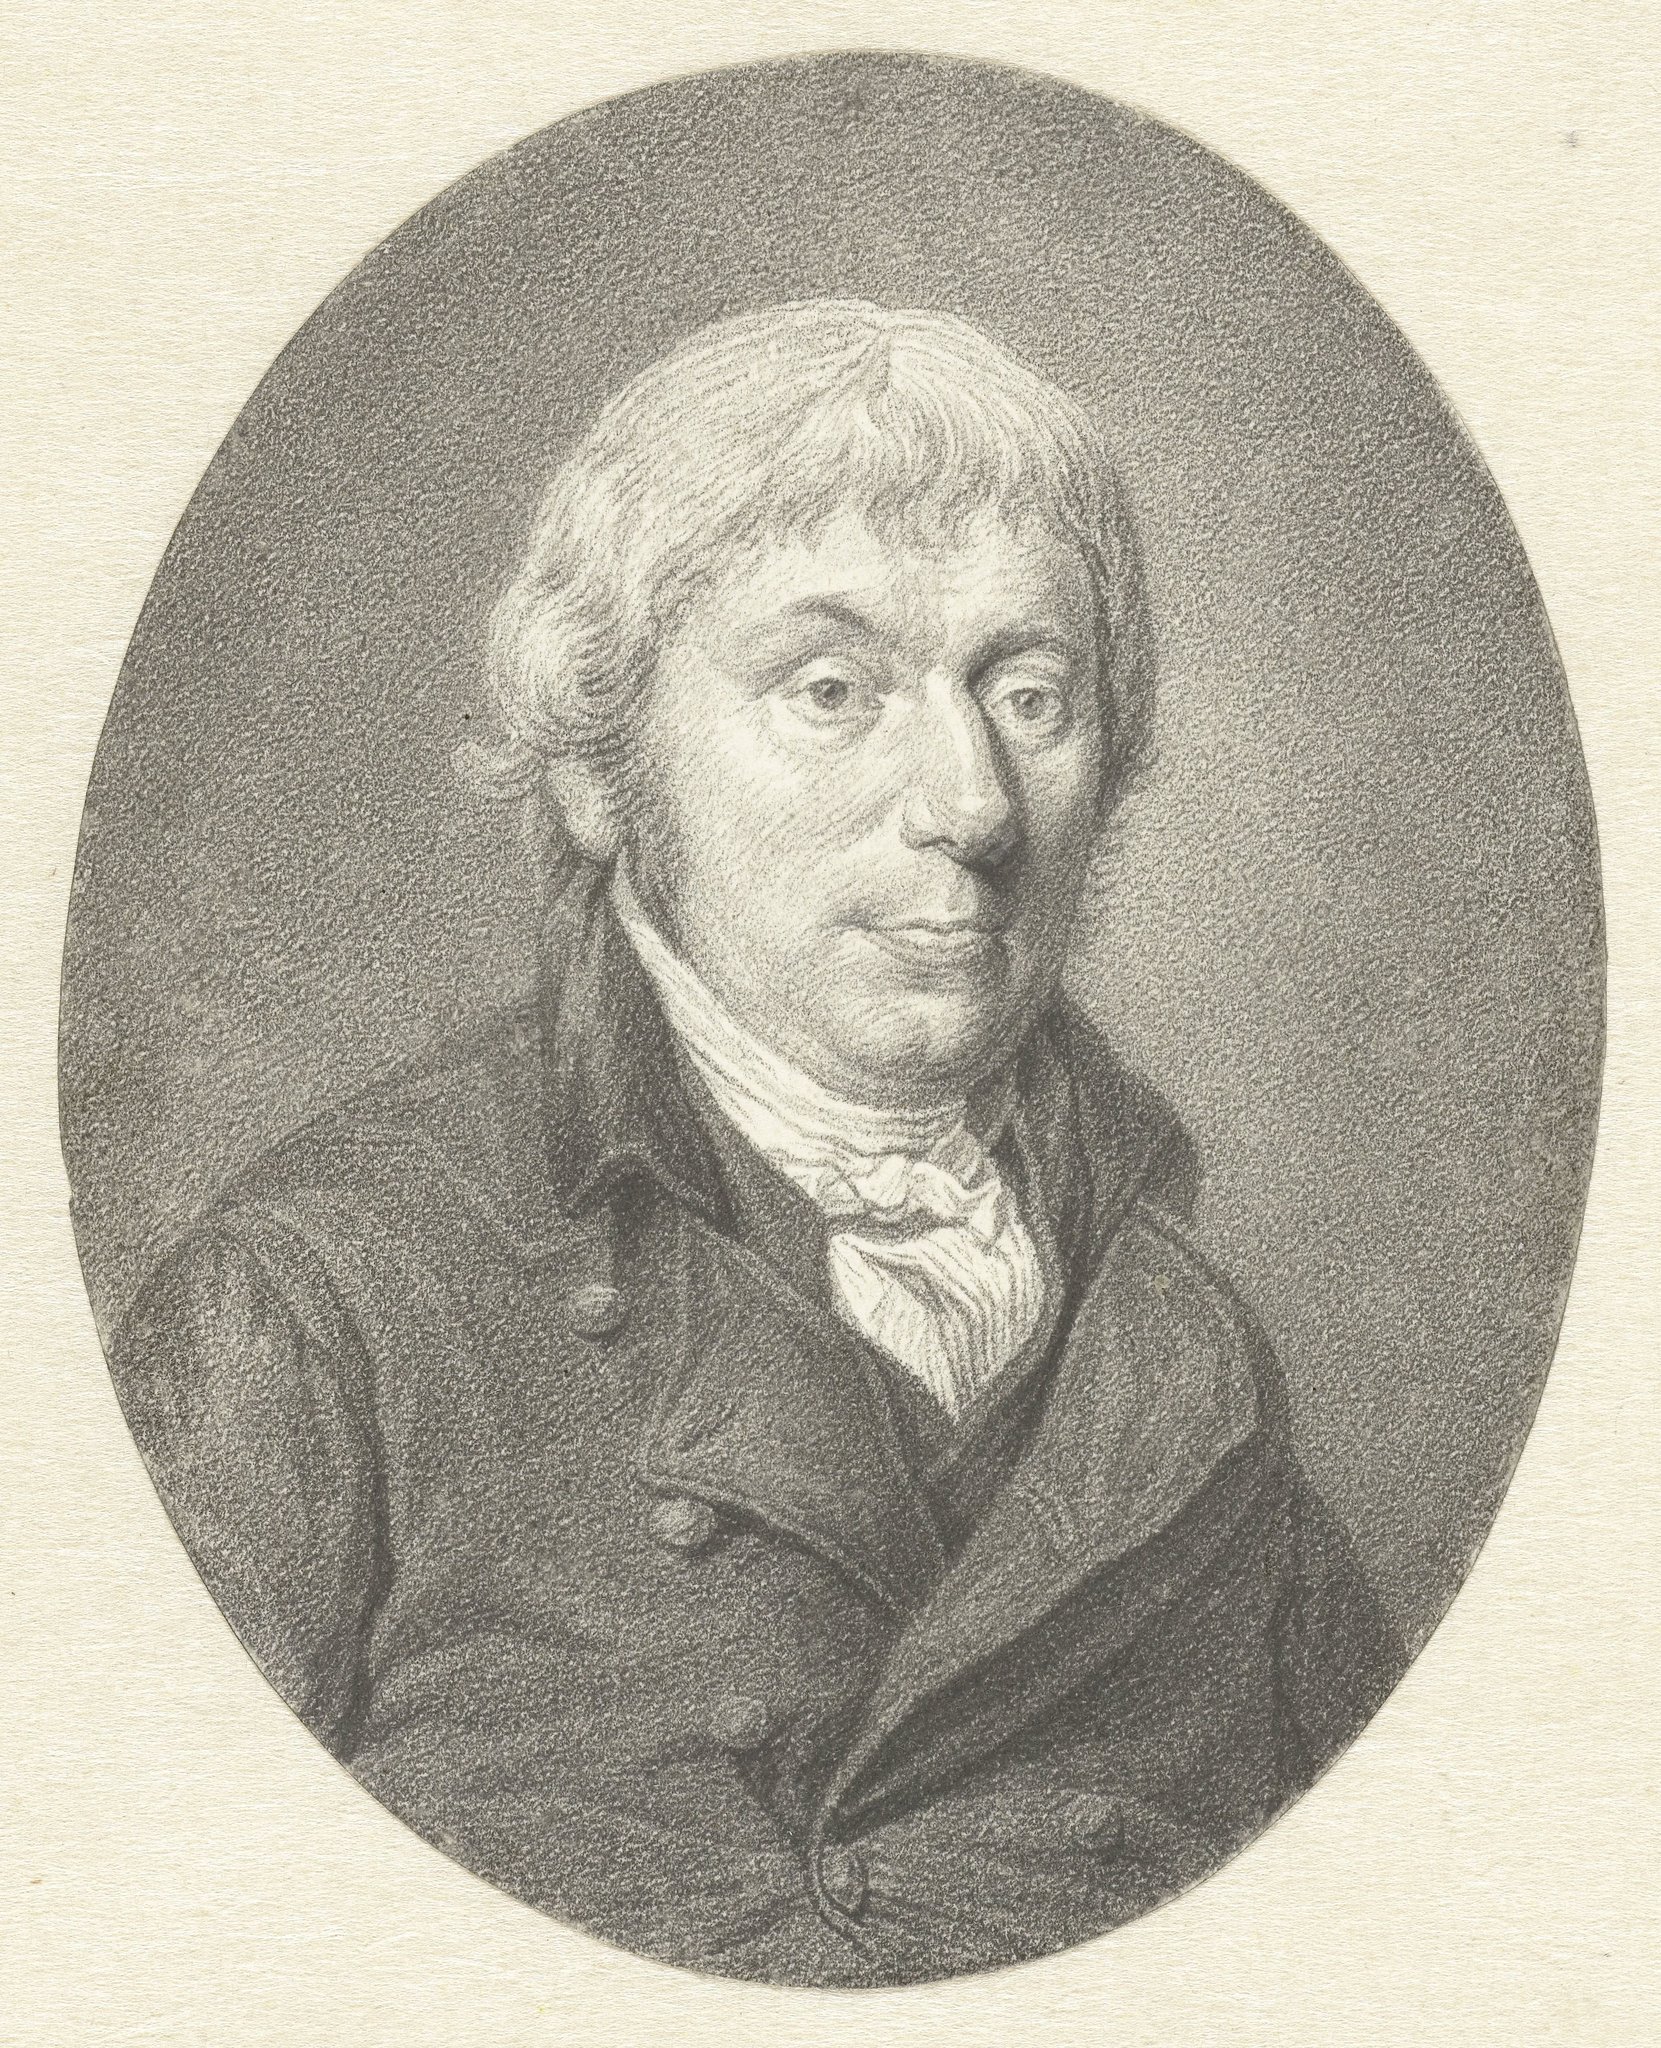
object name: drawing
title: Mansportret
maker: johannes cornelis mertens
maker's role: draughtsman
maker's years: 1742-1823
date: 1752-1823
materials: chalk, paper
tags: anonymous historical person portrayed alone